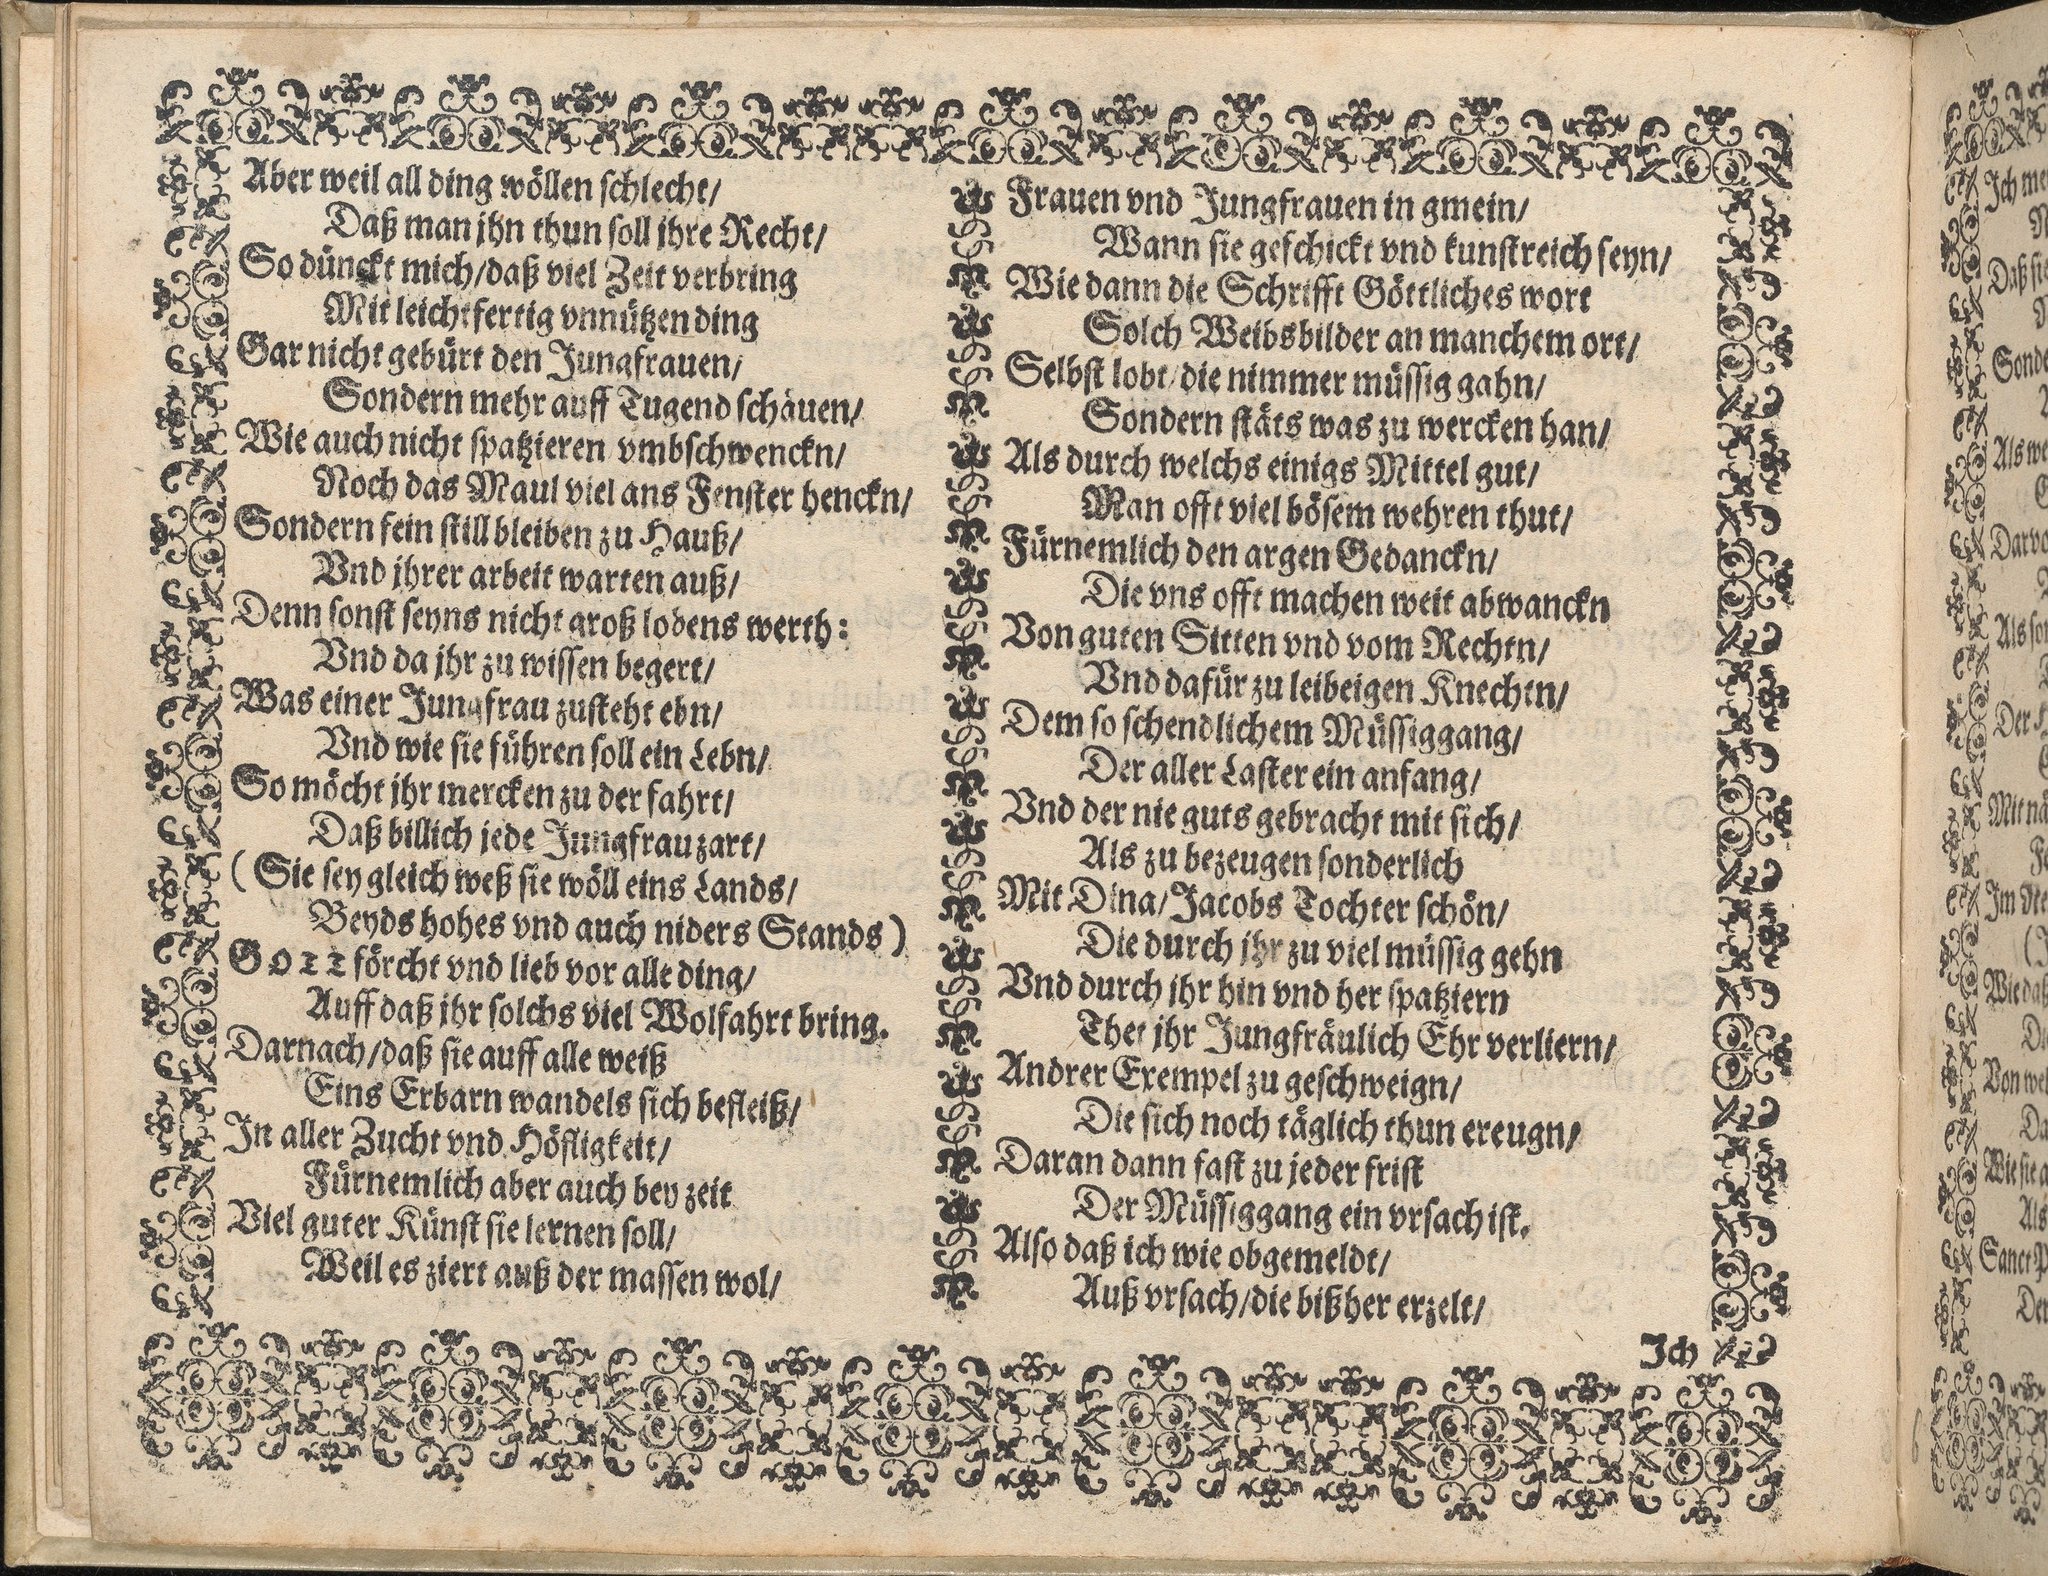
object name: book print ornament architecture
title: Newes Modelbuch in Kupffer (Page, 5r)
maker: johann sibmacher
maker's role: artist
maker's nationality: german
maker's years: 1590-1611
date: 1604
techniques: woodcut